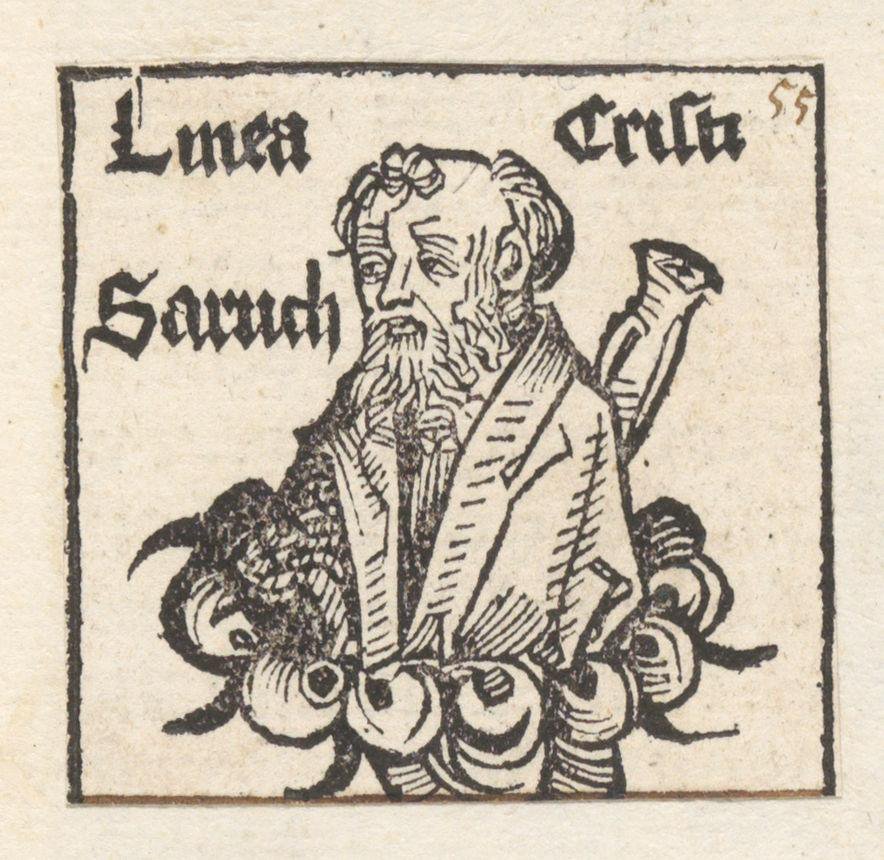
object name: album leaf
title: Saruch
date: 1493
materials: paper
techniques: letterpress printing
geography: nuremberg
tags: persons from the old testament (not in biblical context, nor occurring in legendary/historical extensions included in division 71)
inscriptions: inscription: ‘55’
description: Een bloemkelk met een bebaarde man, naar links gekeerd. De tekst identificeert de man als Serug, vader van Nachor. De voorstelling is een fragment van de stamboom van Christus in de Liber Chronicarum. De prent maakt deel uit van een album.